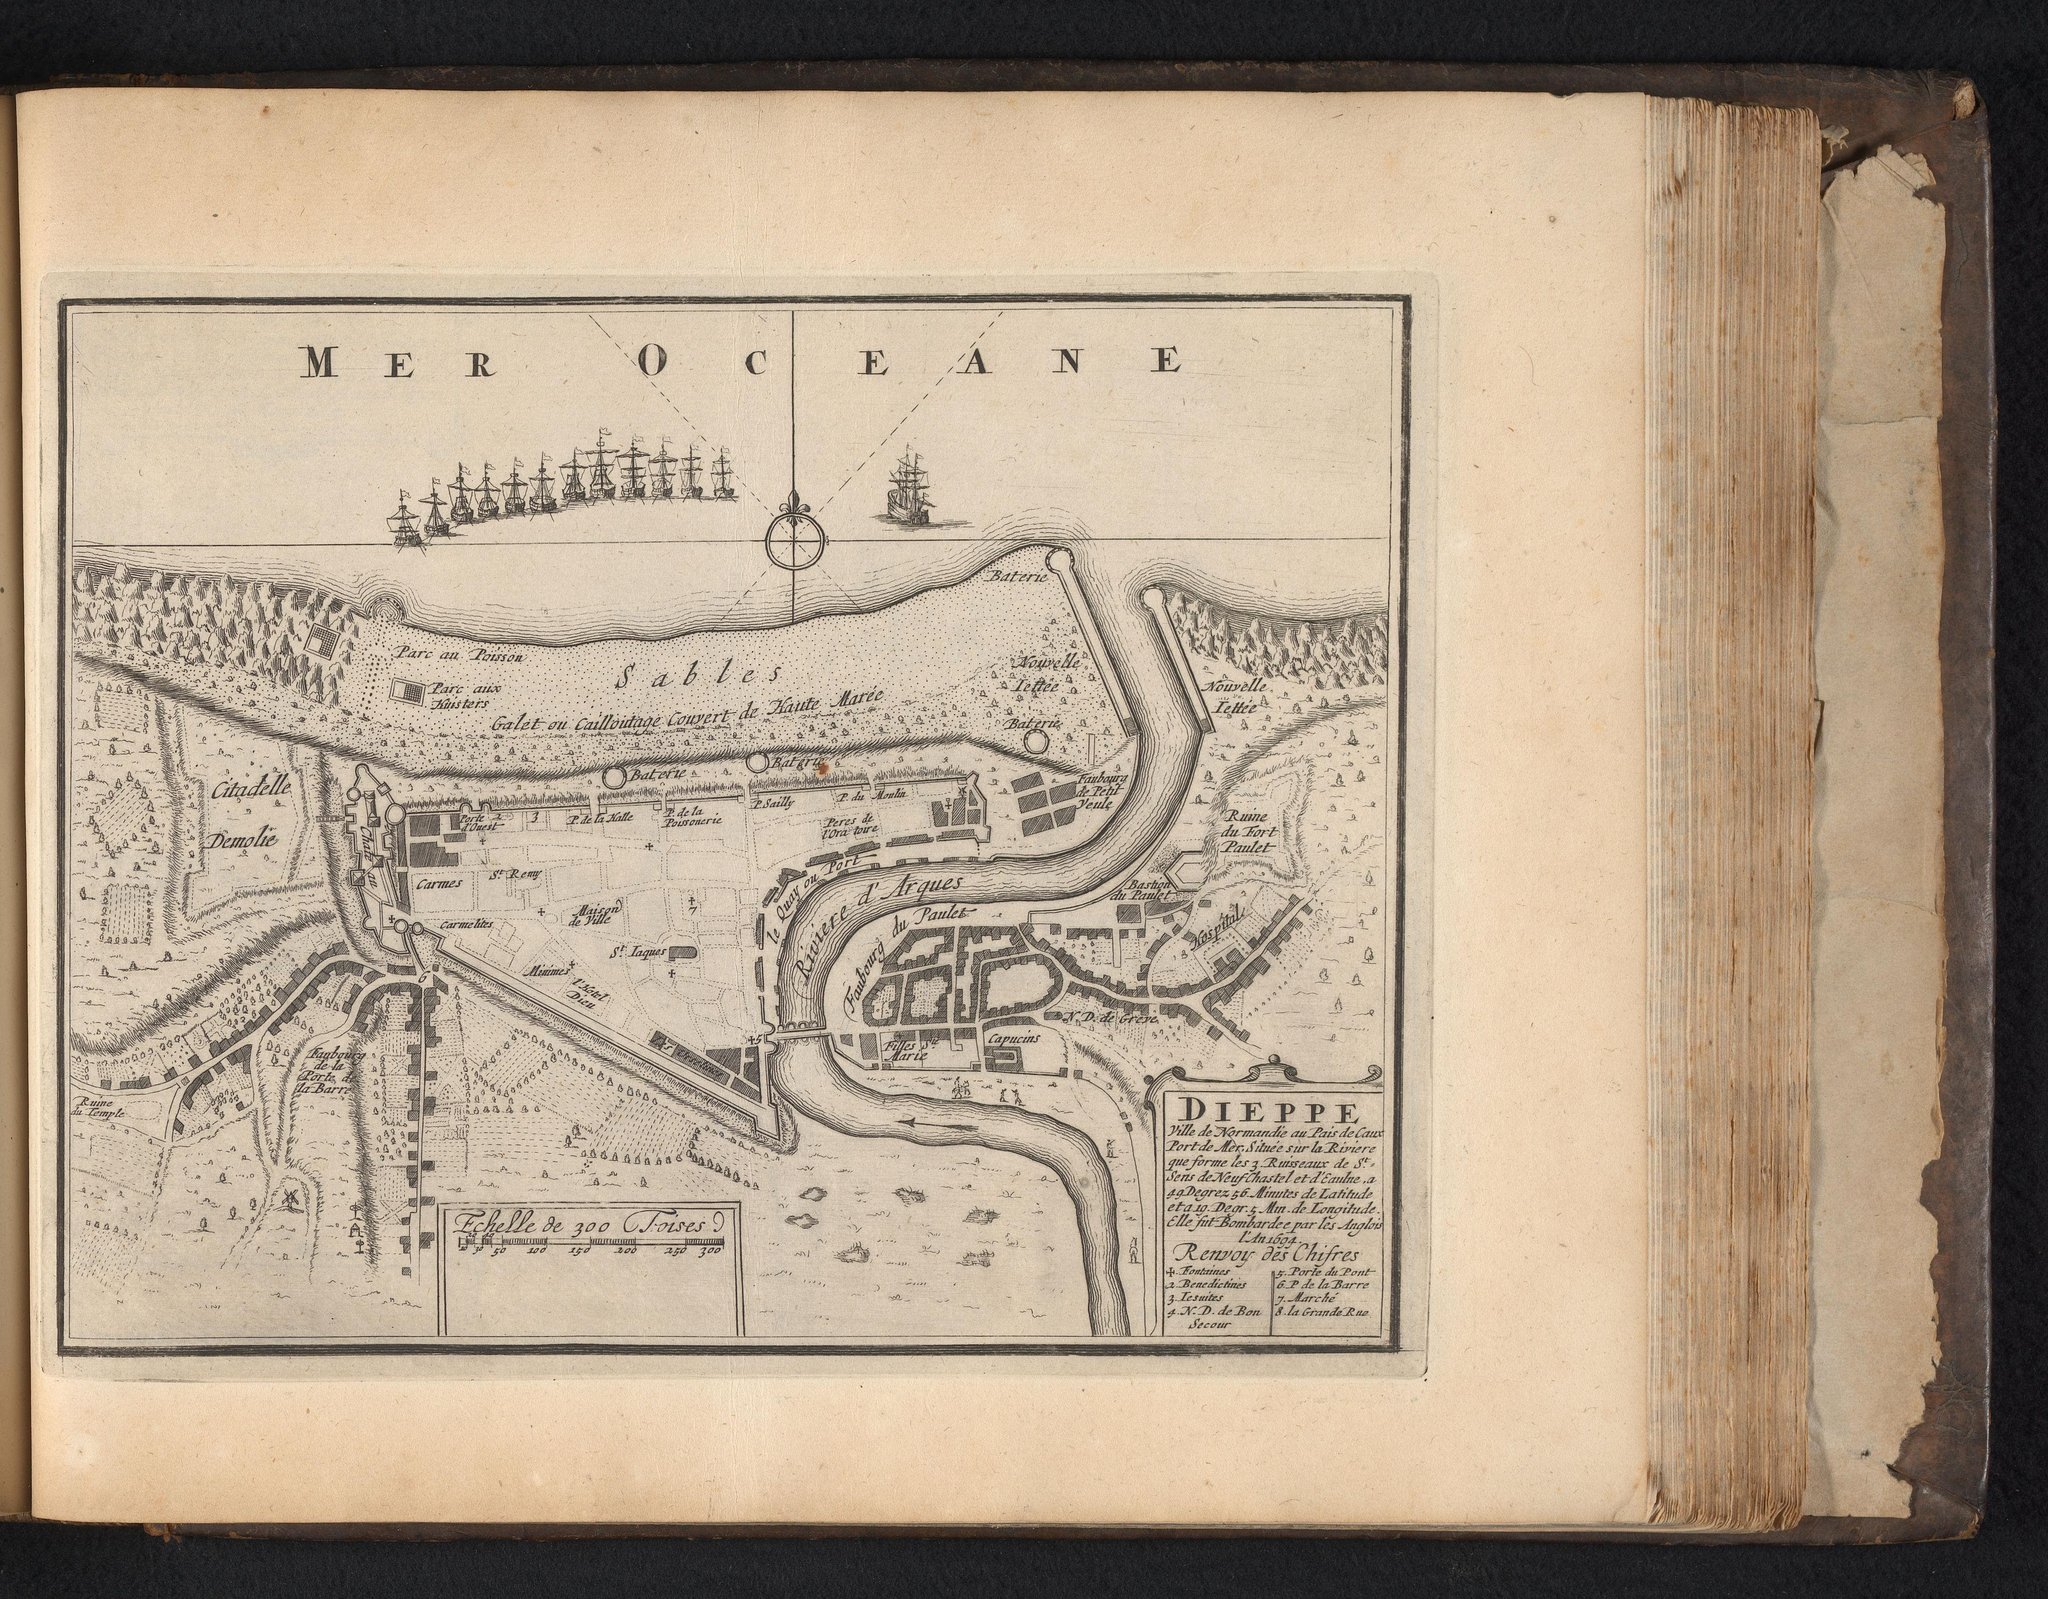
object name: print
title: Les forces de l'Europe, ou description des principales villes, avec leurs fortifications : dessignées par les meilleurs ingenieurs, particulierement celles (...) de la France, dont les plans ont esté levez par M. de Vauban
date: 1695-1697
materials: paper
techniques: etching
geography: paris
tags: maps of cities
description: Plattegrond van de Franse havenstad Dieppe, gebombardeerd door de geallieerden in juli 1694. Onderdeel van het achtste deel (1697) van het prentwerk waarin gebundeld zijn de acht delen van Les forces de l'Europe uitgegeven tussen 1693-1697. Het prentwerk bestaat uit 175 platen met plannen (afkomstig van Sébastien Le Prestre, Seigneur de Vauban) van vermaarde sterke steden en vestingen in de Negenjarige Oorlog. Titel en opschriften in het Frans.